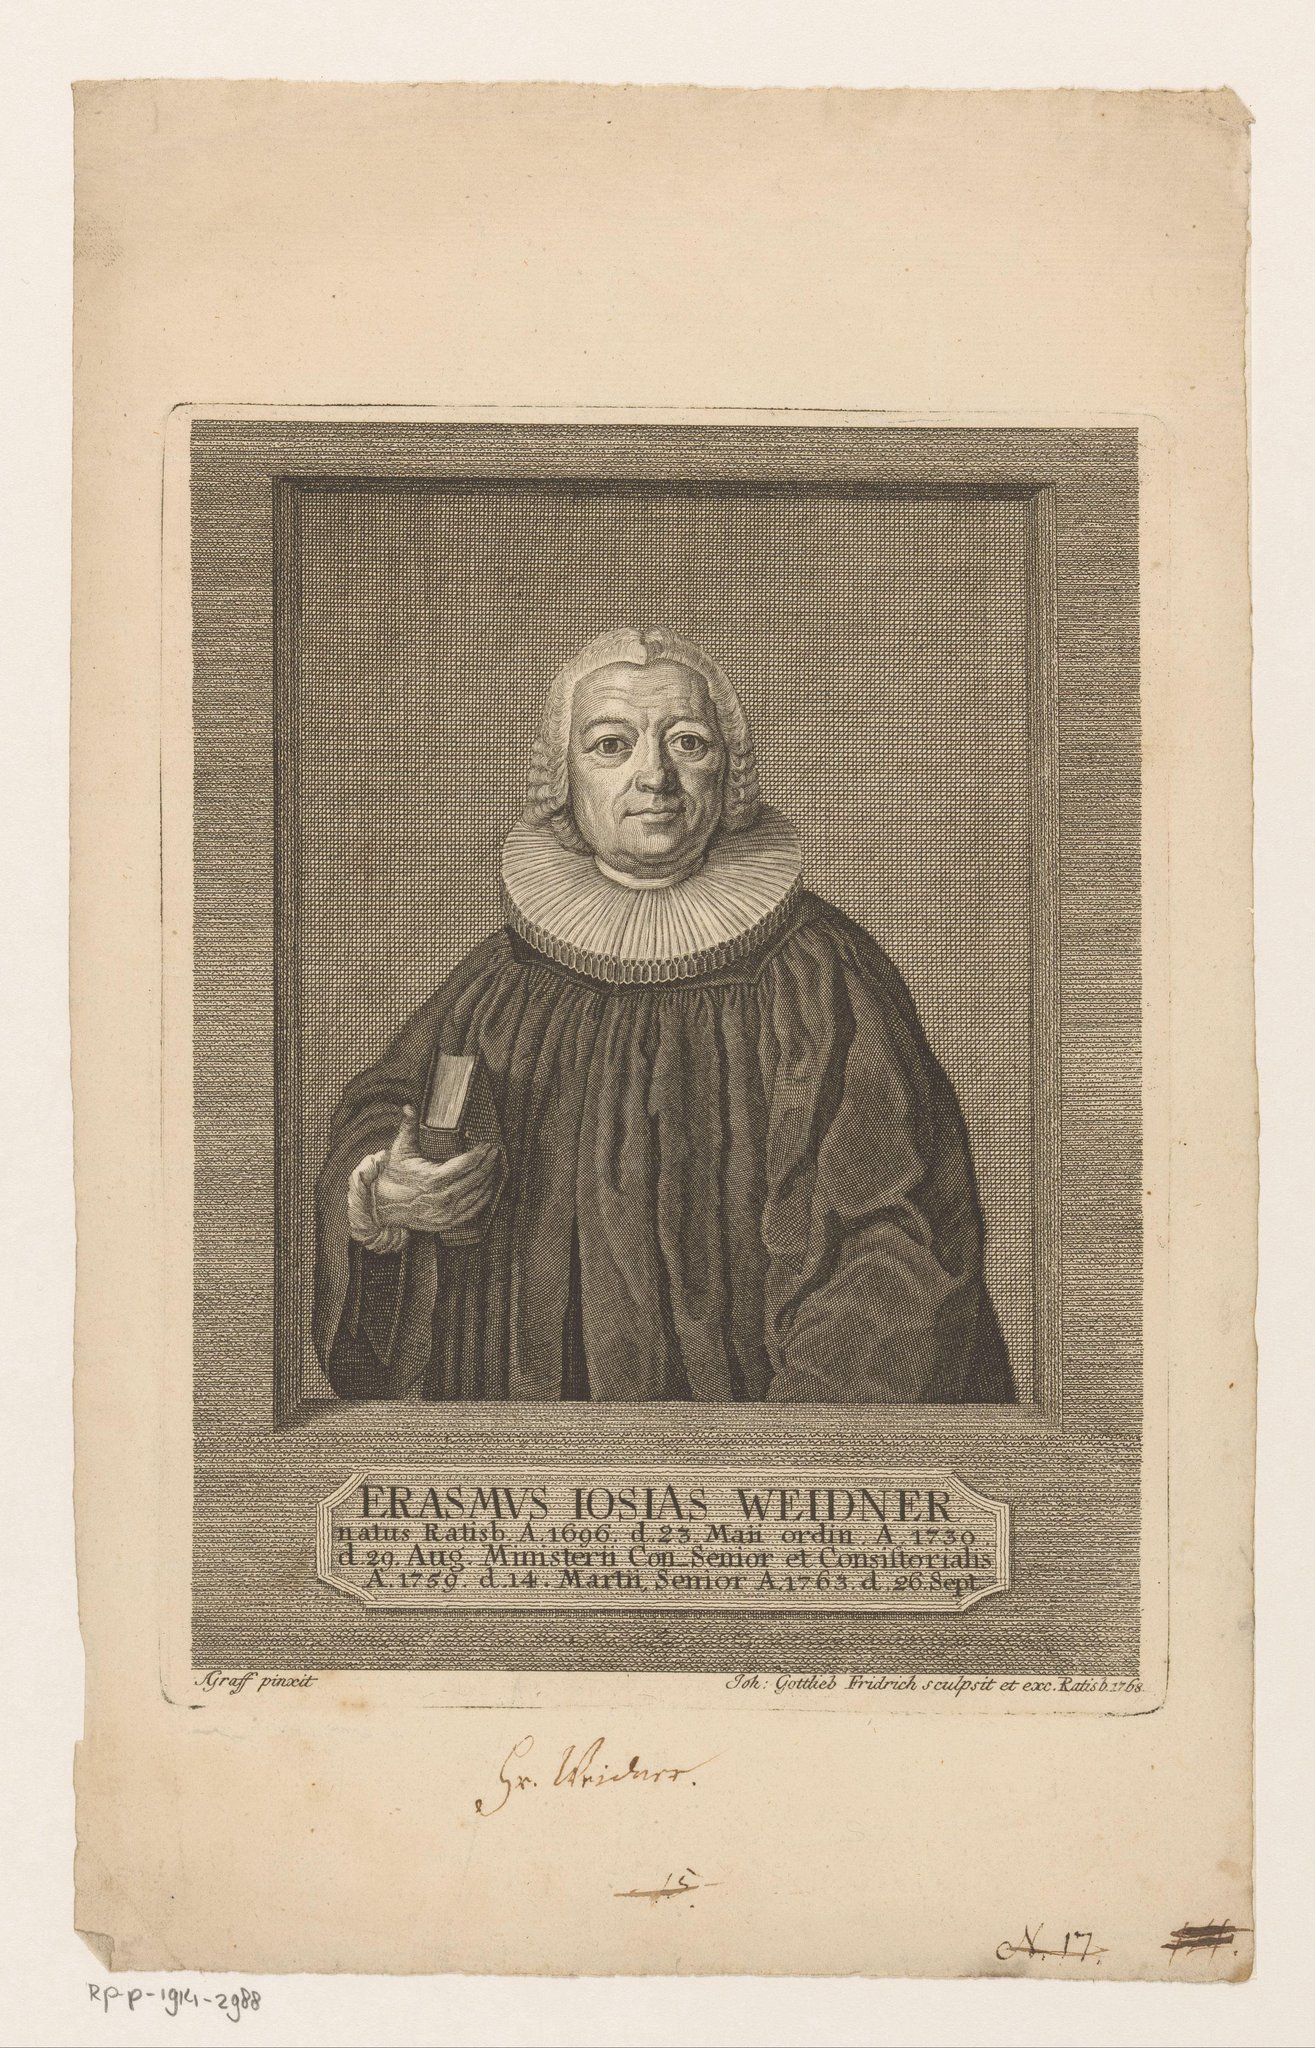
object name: print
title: Portret van Erasmus Josias Weidner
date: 1768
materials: paper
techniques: engraving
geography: regensburg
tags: historical persons, book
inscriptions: collector's mark: Lugt 2228